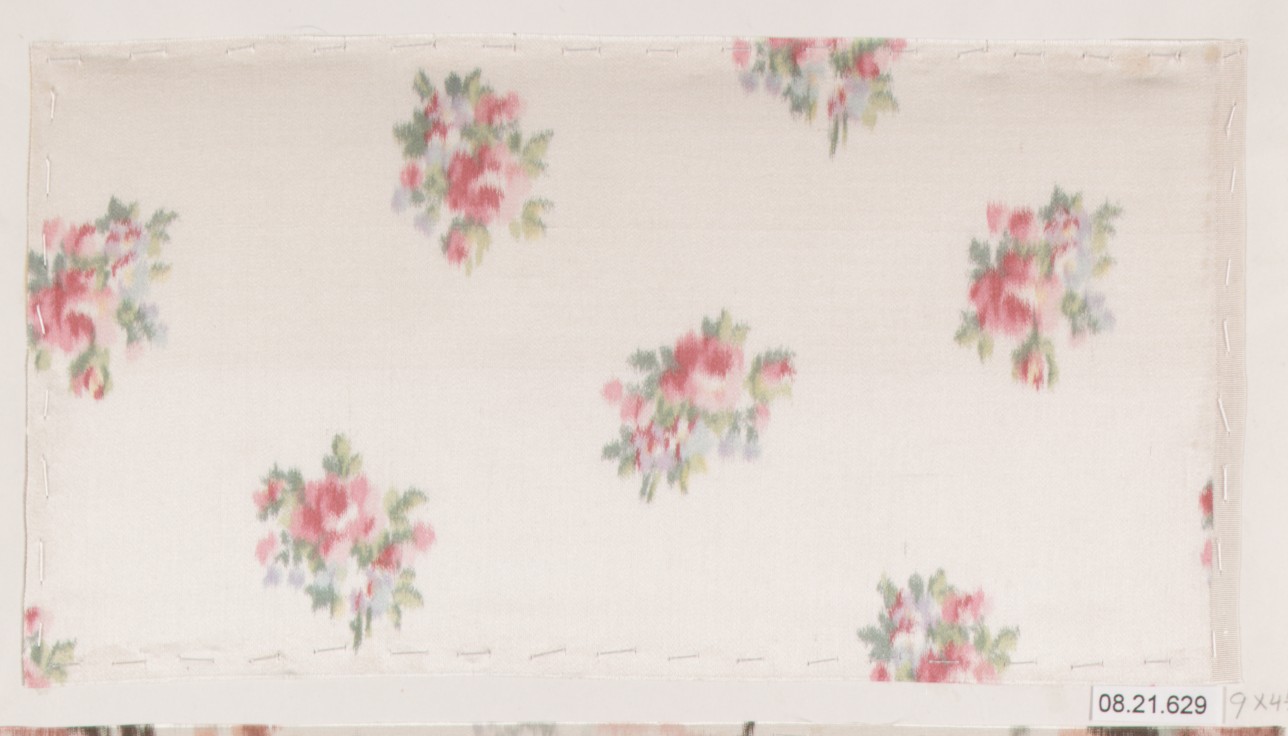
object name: textile sample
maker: Anonymous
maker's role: designer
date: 1900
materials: silk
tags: flowers